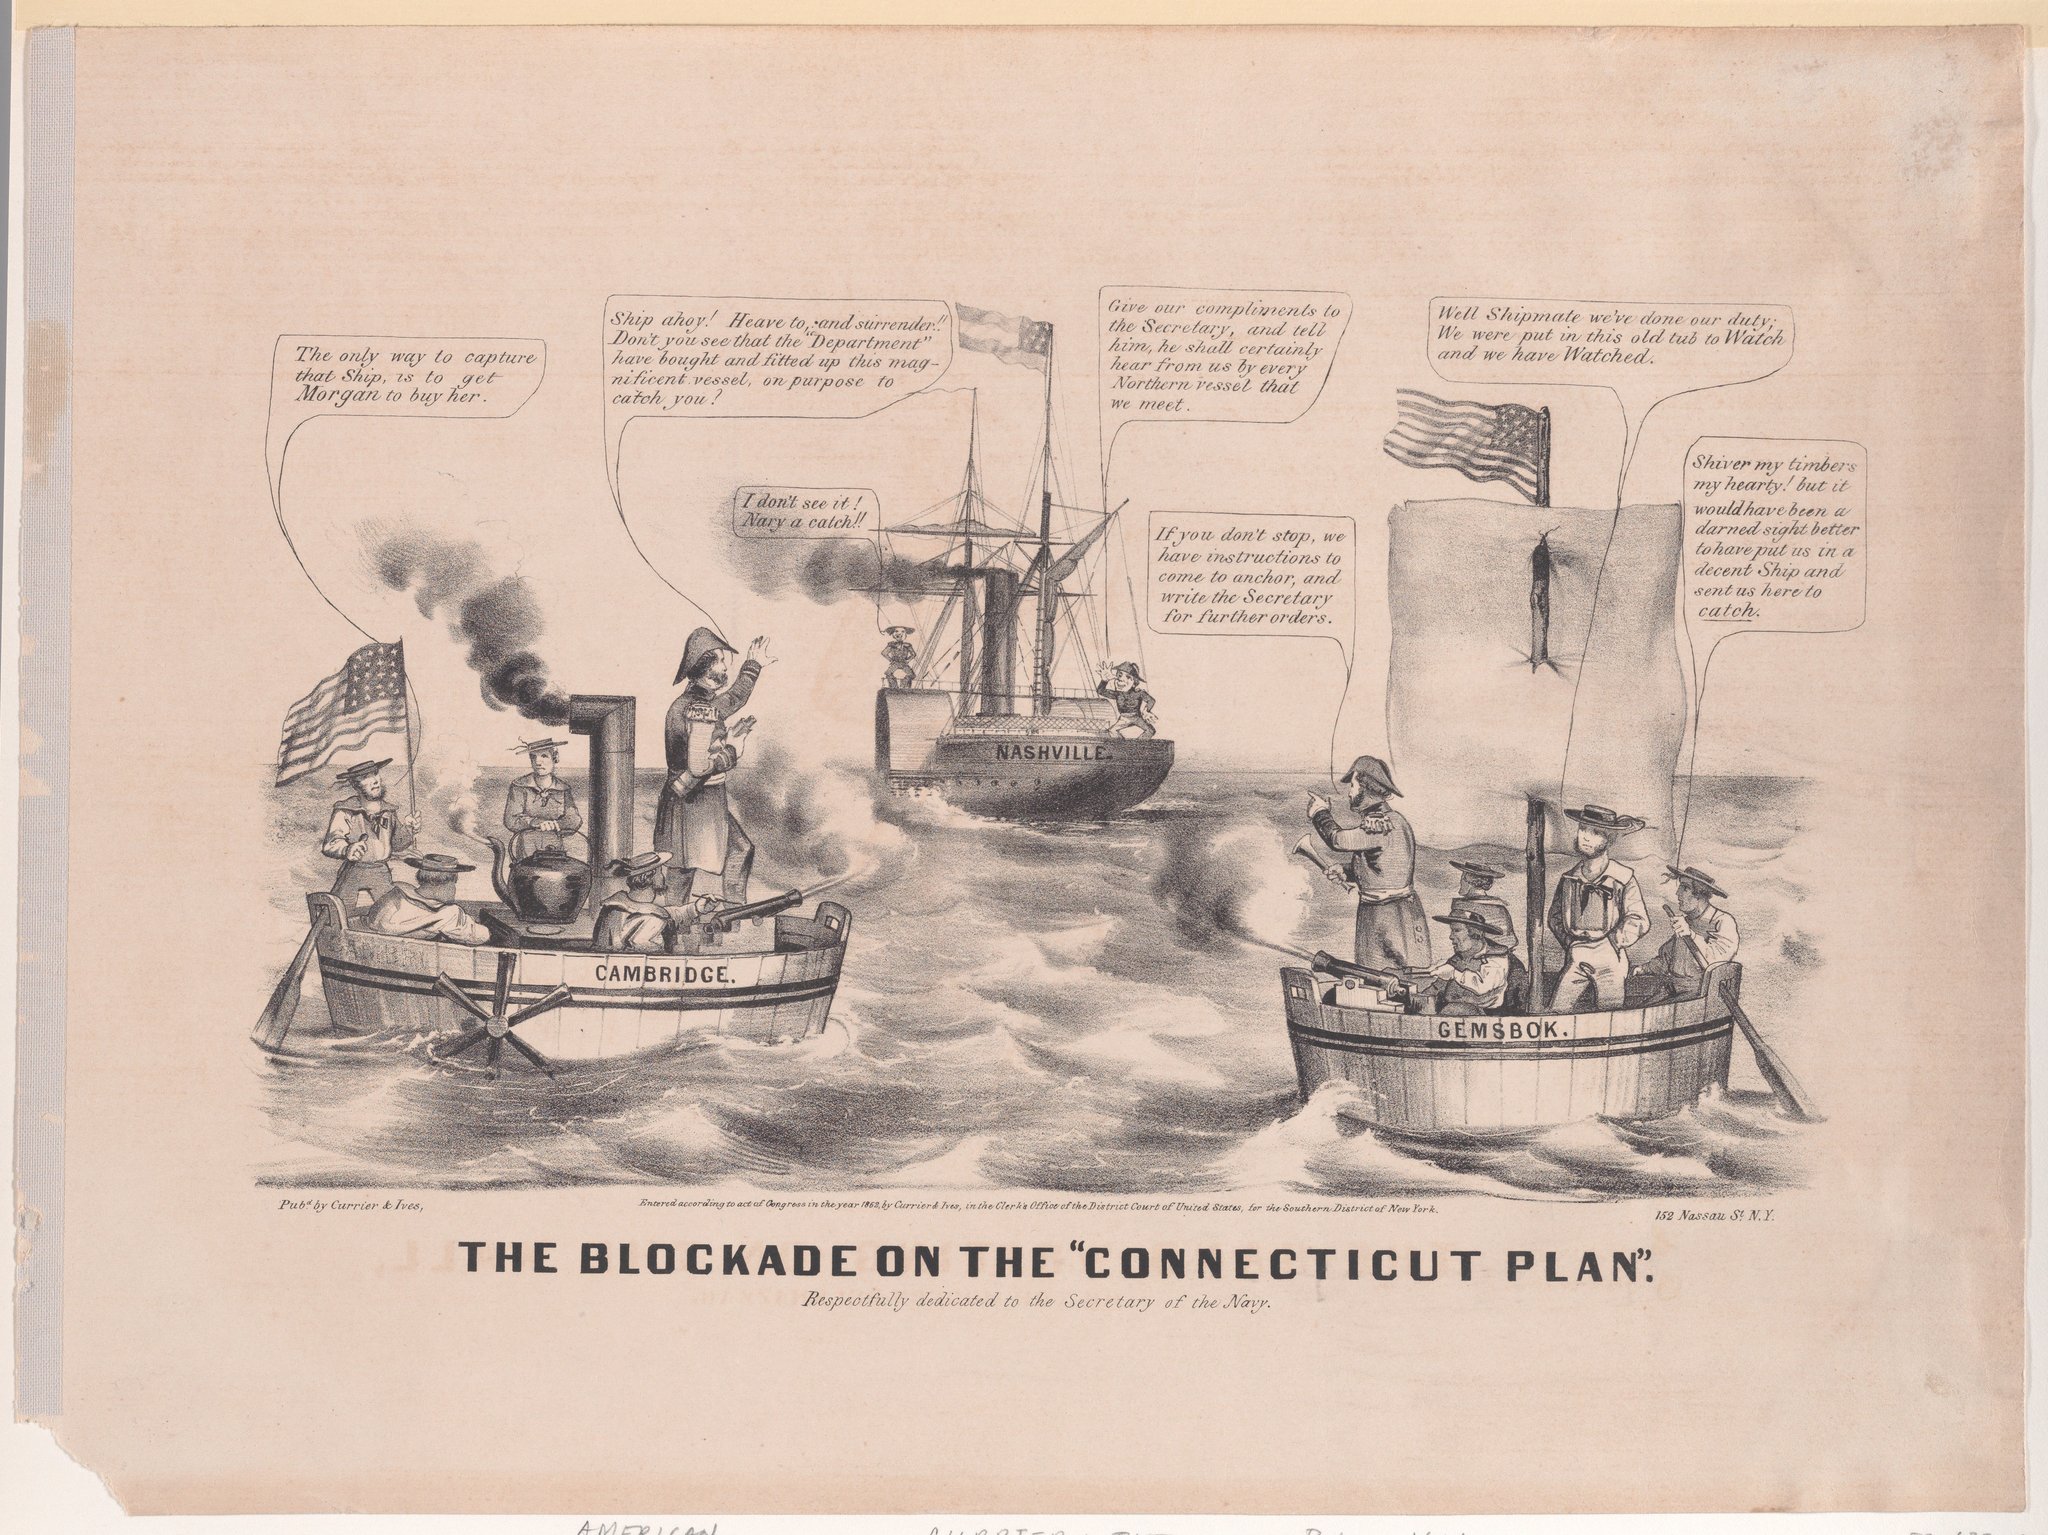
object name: print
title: The Blocade on the "Connecticut Plan"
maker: currier & ives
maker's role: publisher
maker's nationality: american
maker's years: 1857-1907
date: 1862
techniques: lithograph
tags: satire,navy,american civil war,men,boats,politics